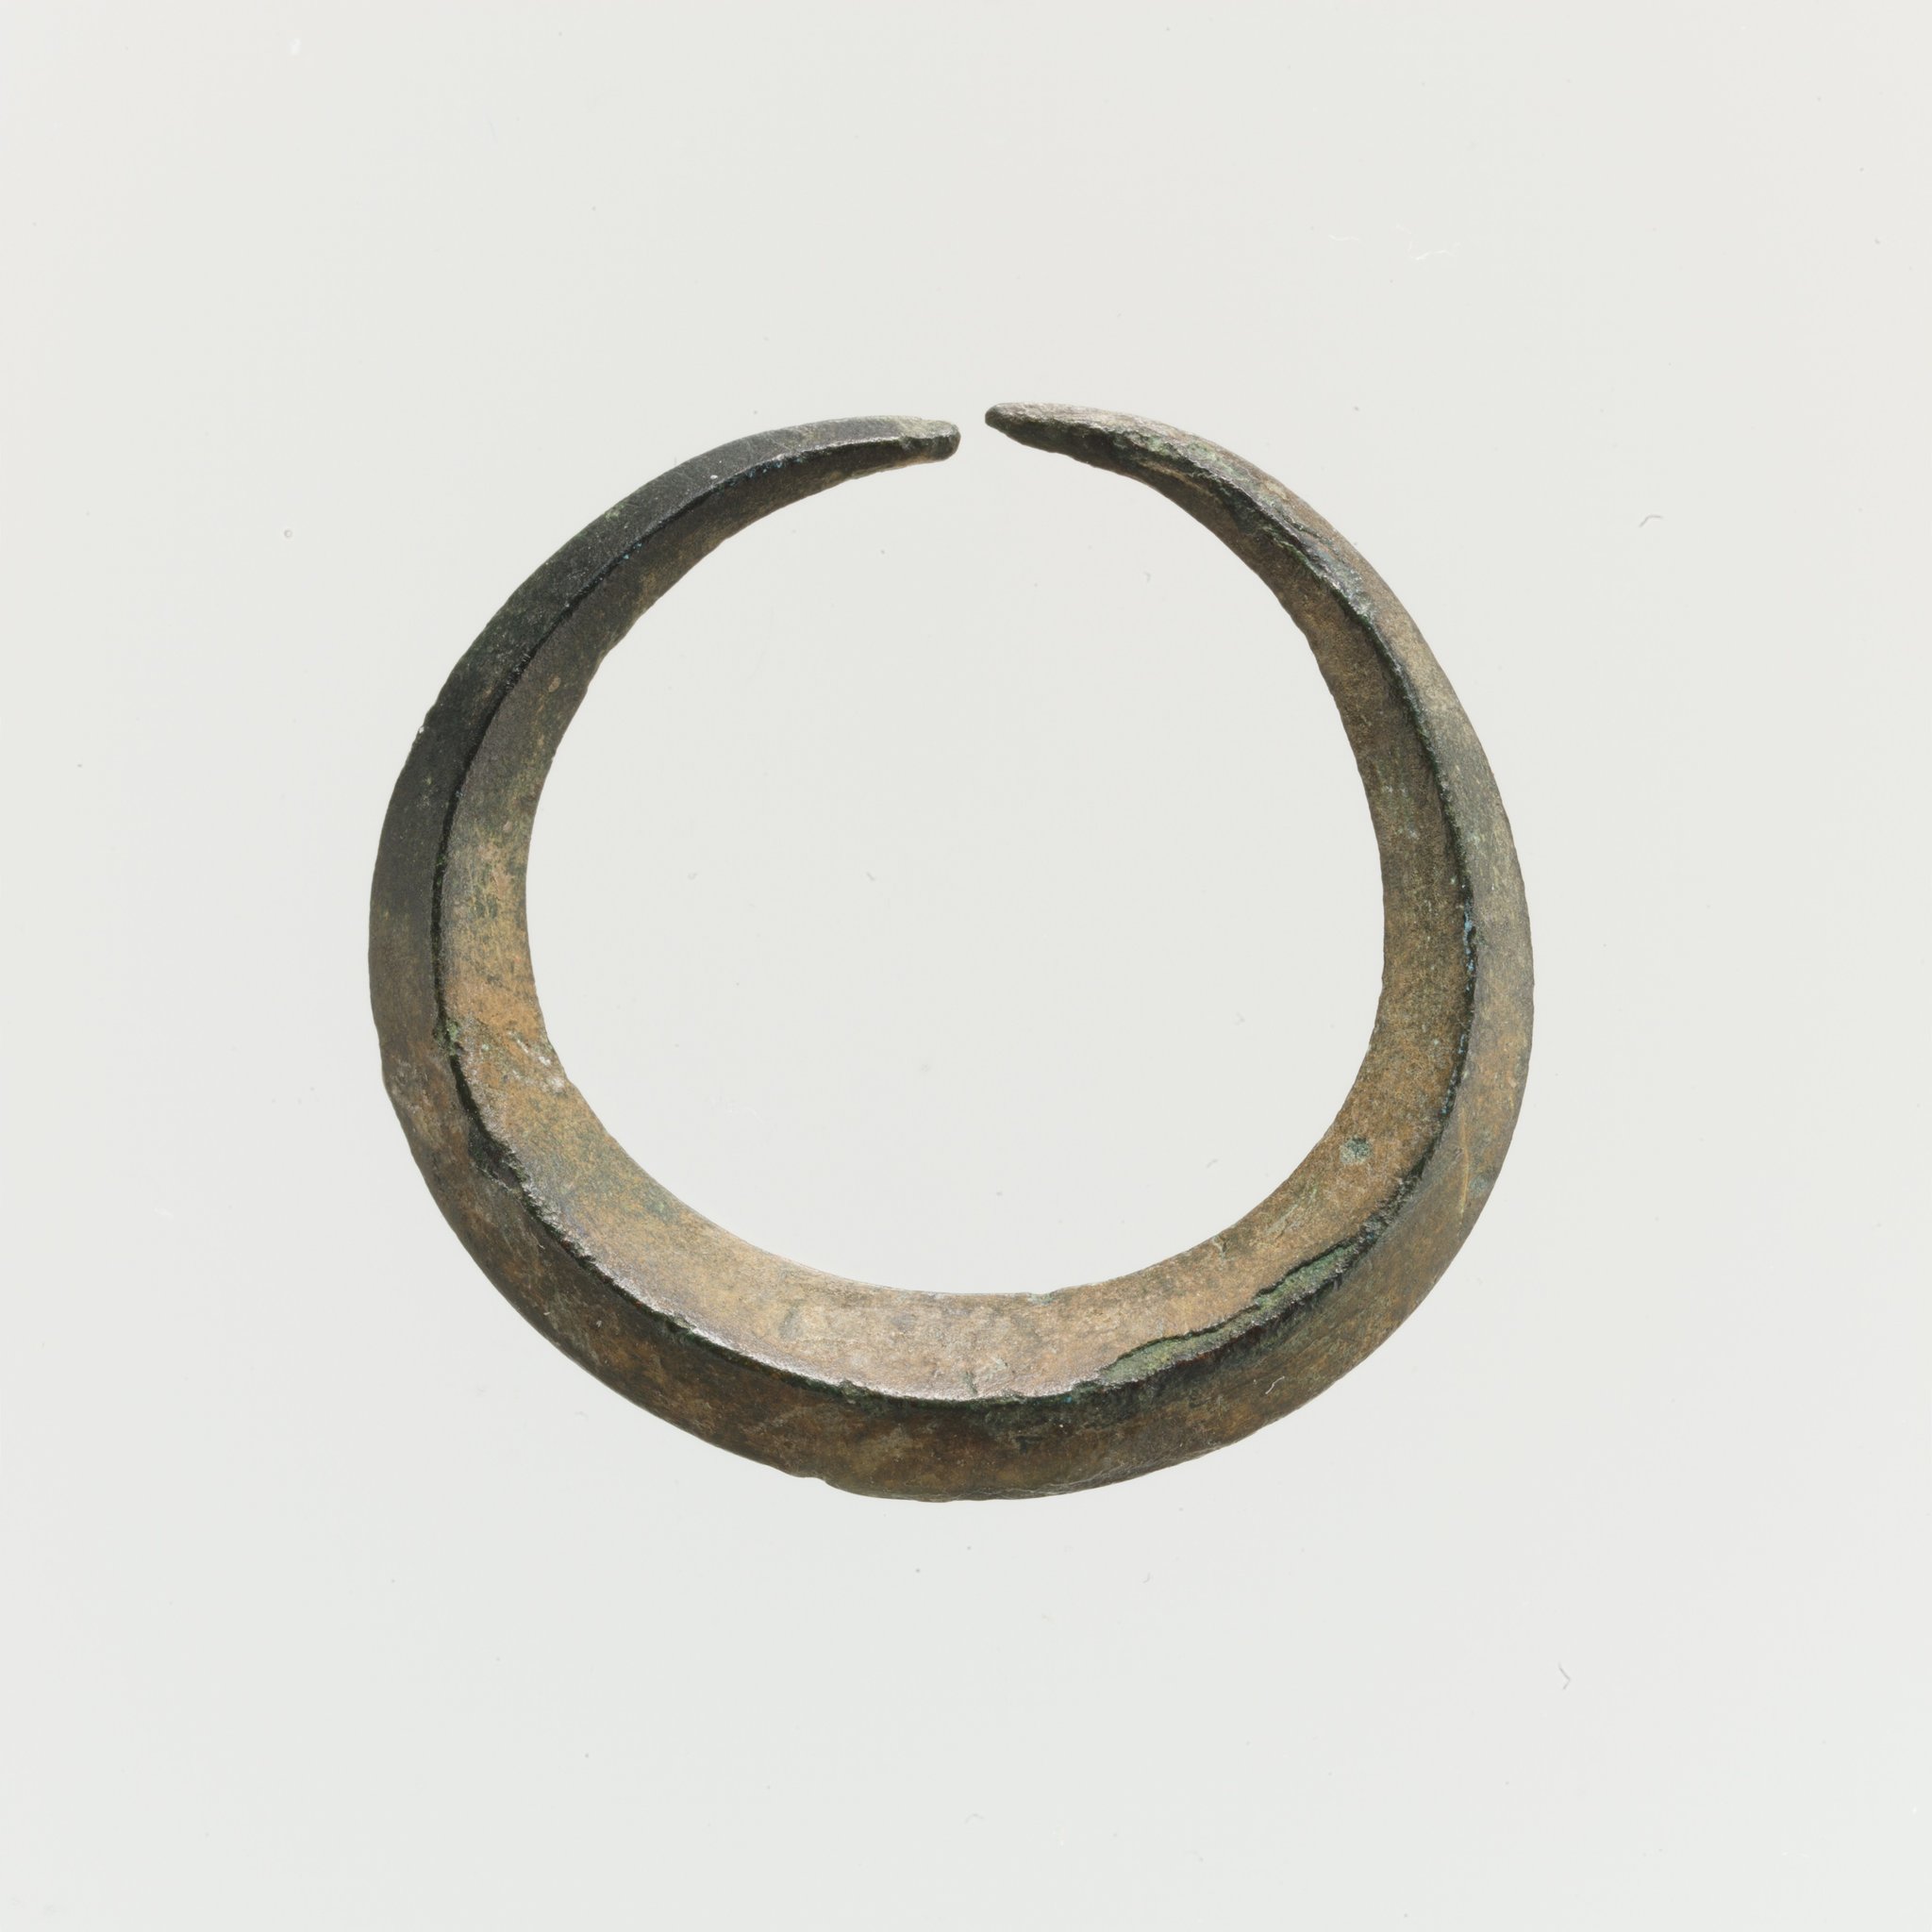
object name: earring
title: Bronze annular earring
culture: minoan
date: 2000-1001 BCE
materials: bronze